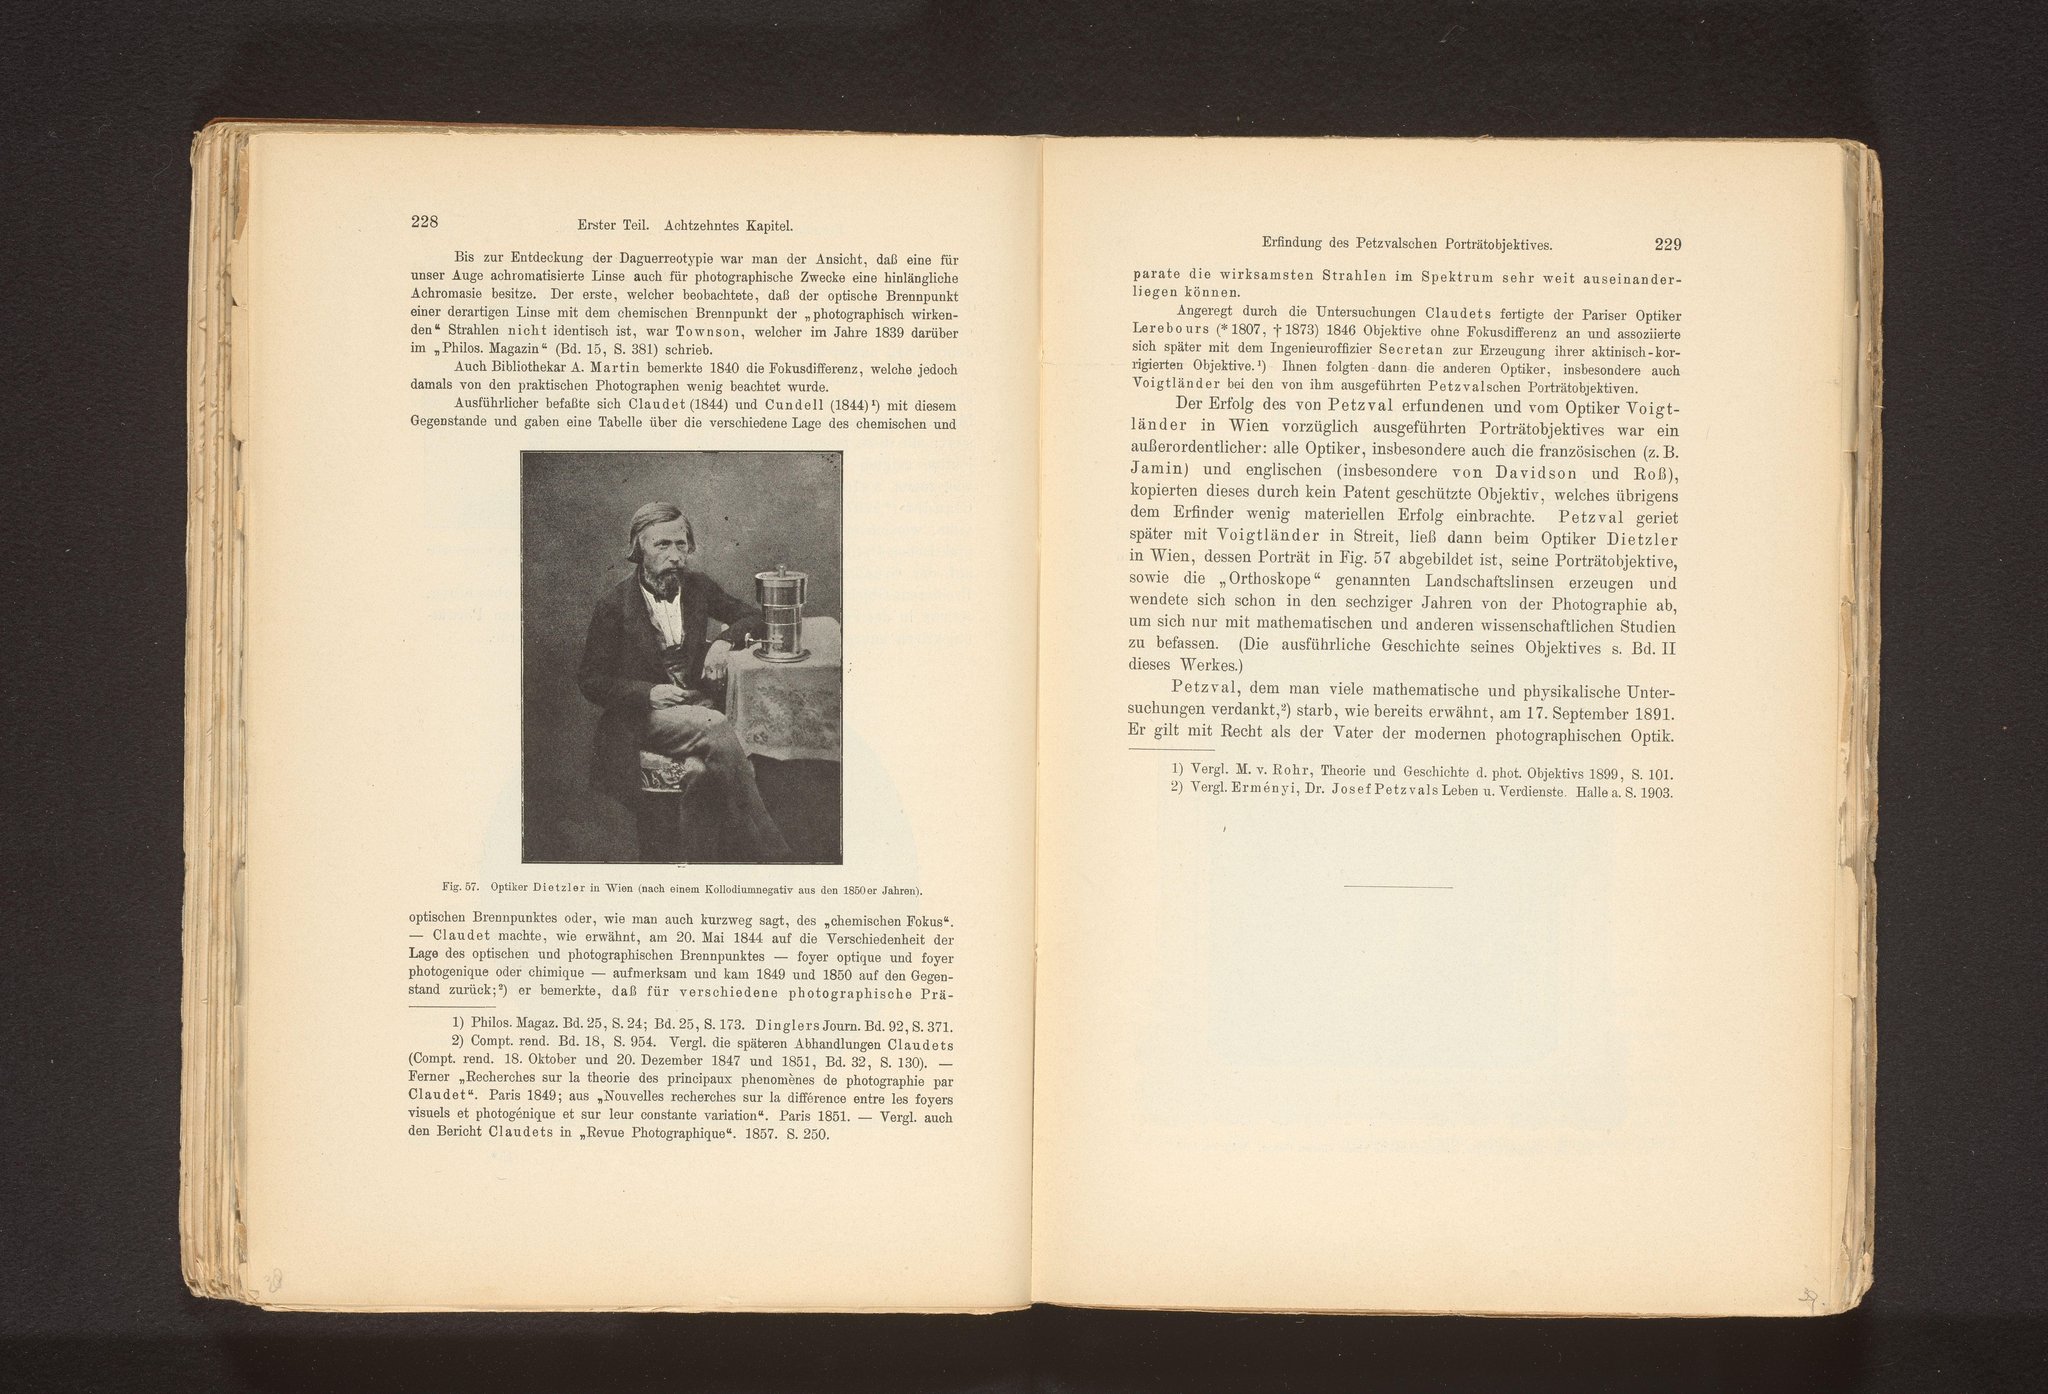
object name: photomechanical print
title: Portret van Carl Dietzler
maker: Anonymous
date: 1900-1905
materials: paper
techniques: autotype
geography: vienna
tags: spectacle-maker, optician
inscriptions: number: ‘Fig. 57.’